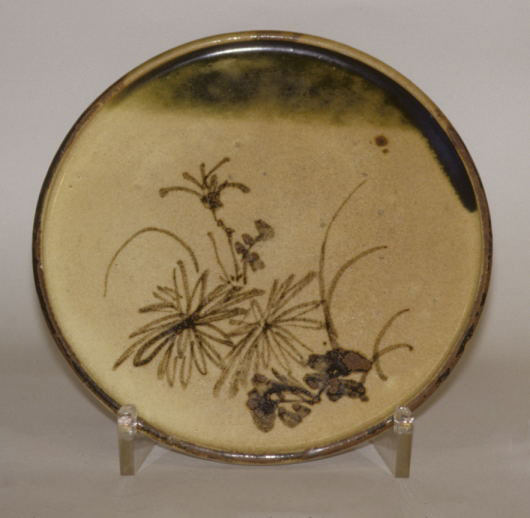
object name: plate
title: Plate with Chrysanthemum Design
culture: japanese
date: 1800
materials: iron, stoneware